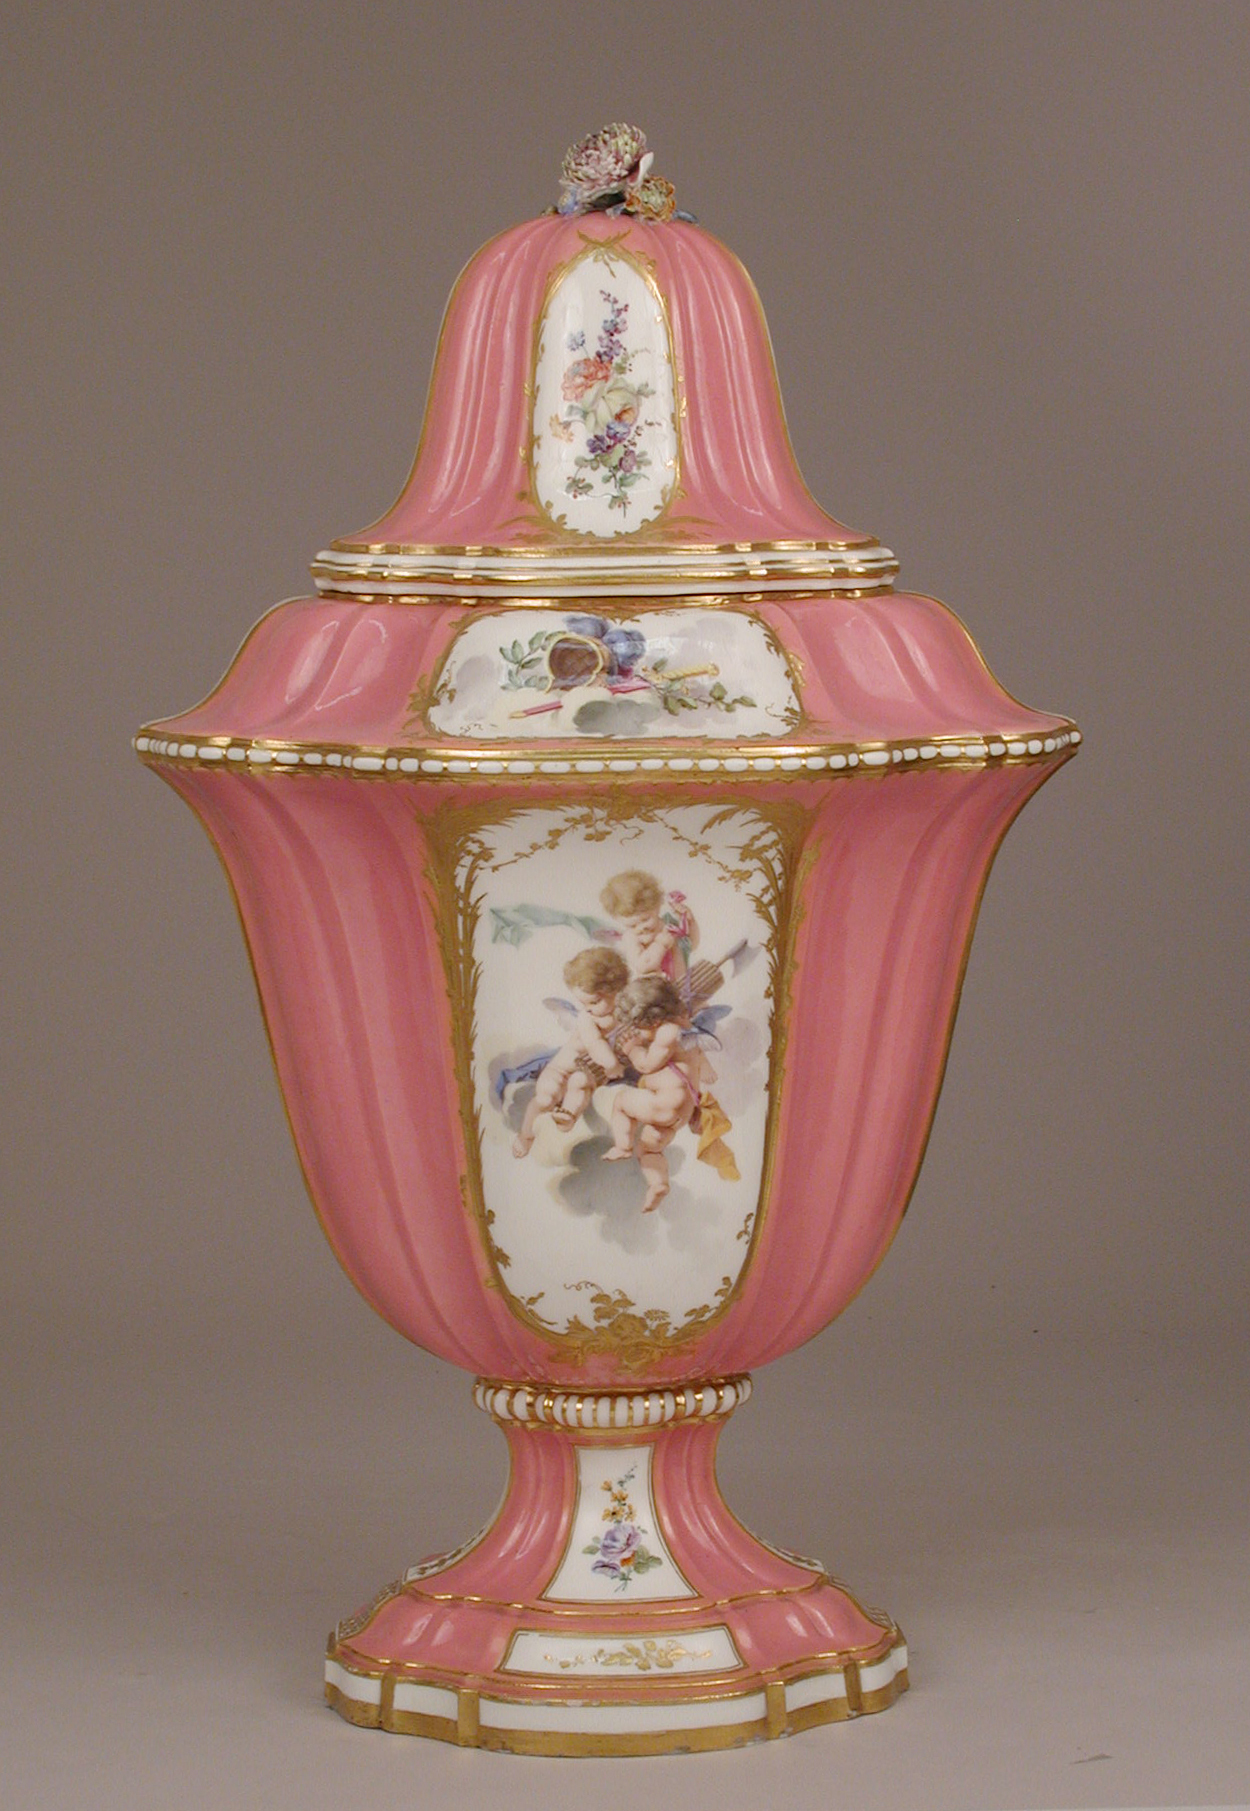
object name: vase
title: Vase (vase Boileau) (part of a set)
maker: sèvres manufactory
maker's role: manufactory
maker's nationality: french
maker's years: 1740-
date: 1758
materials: soft paste porcelain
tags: swords,cupid,flowers